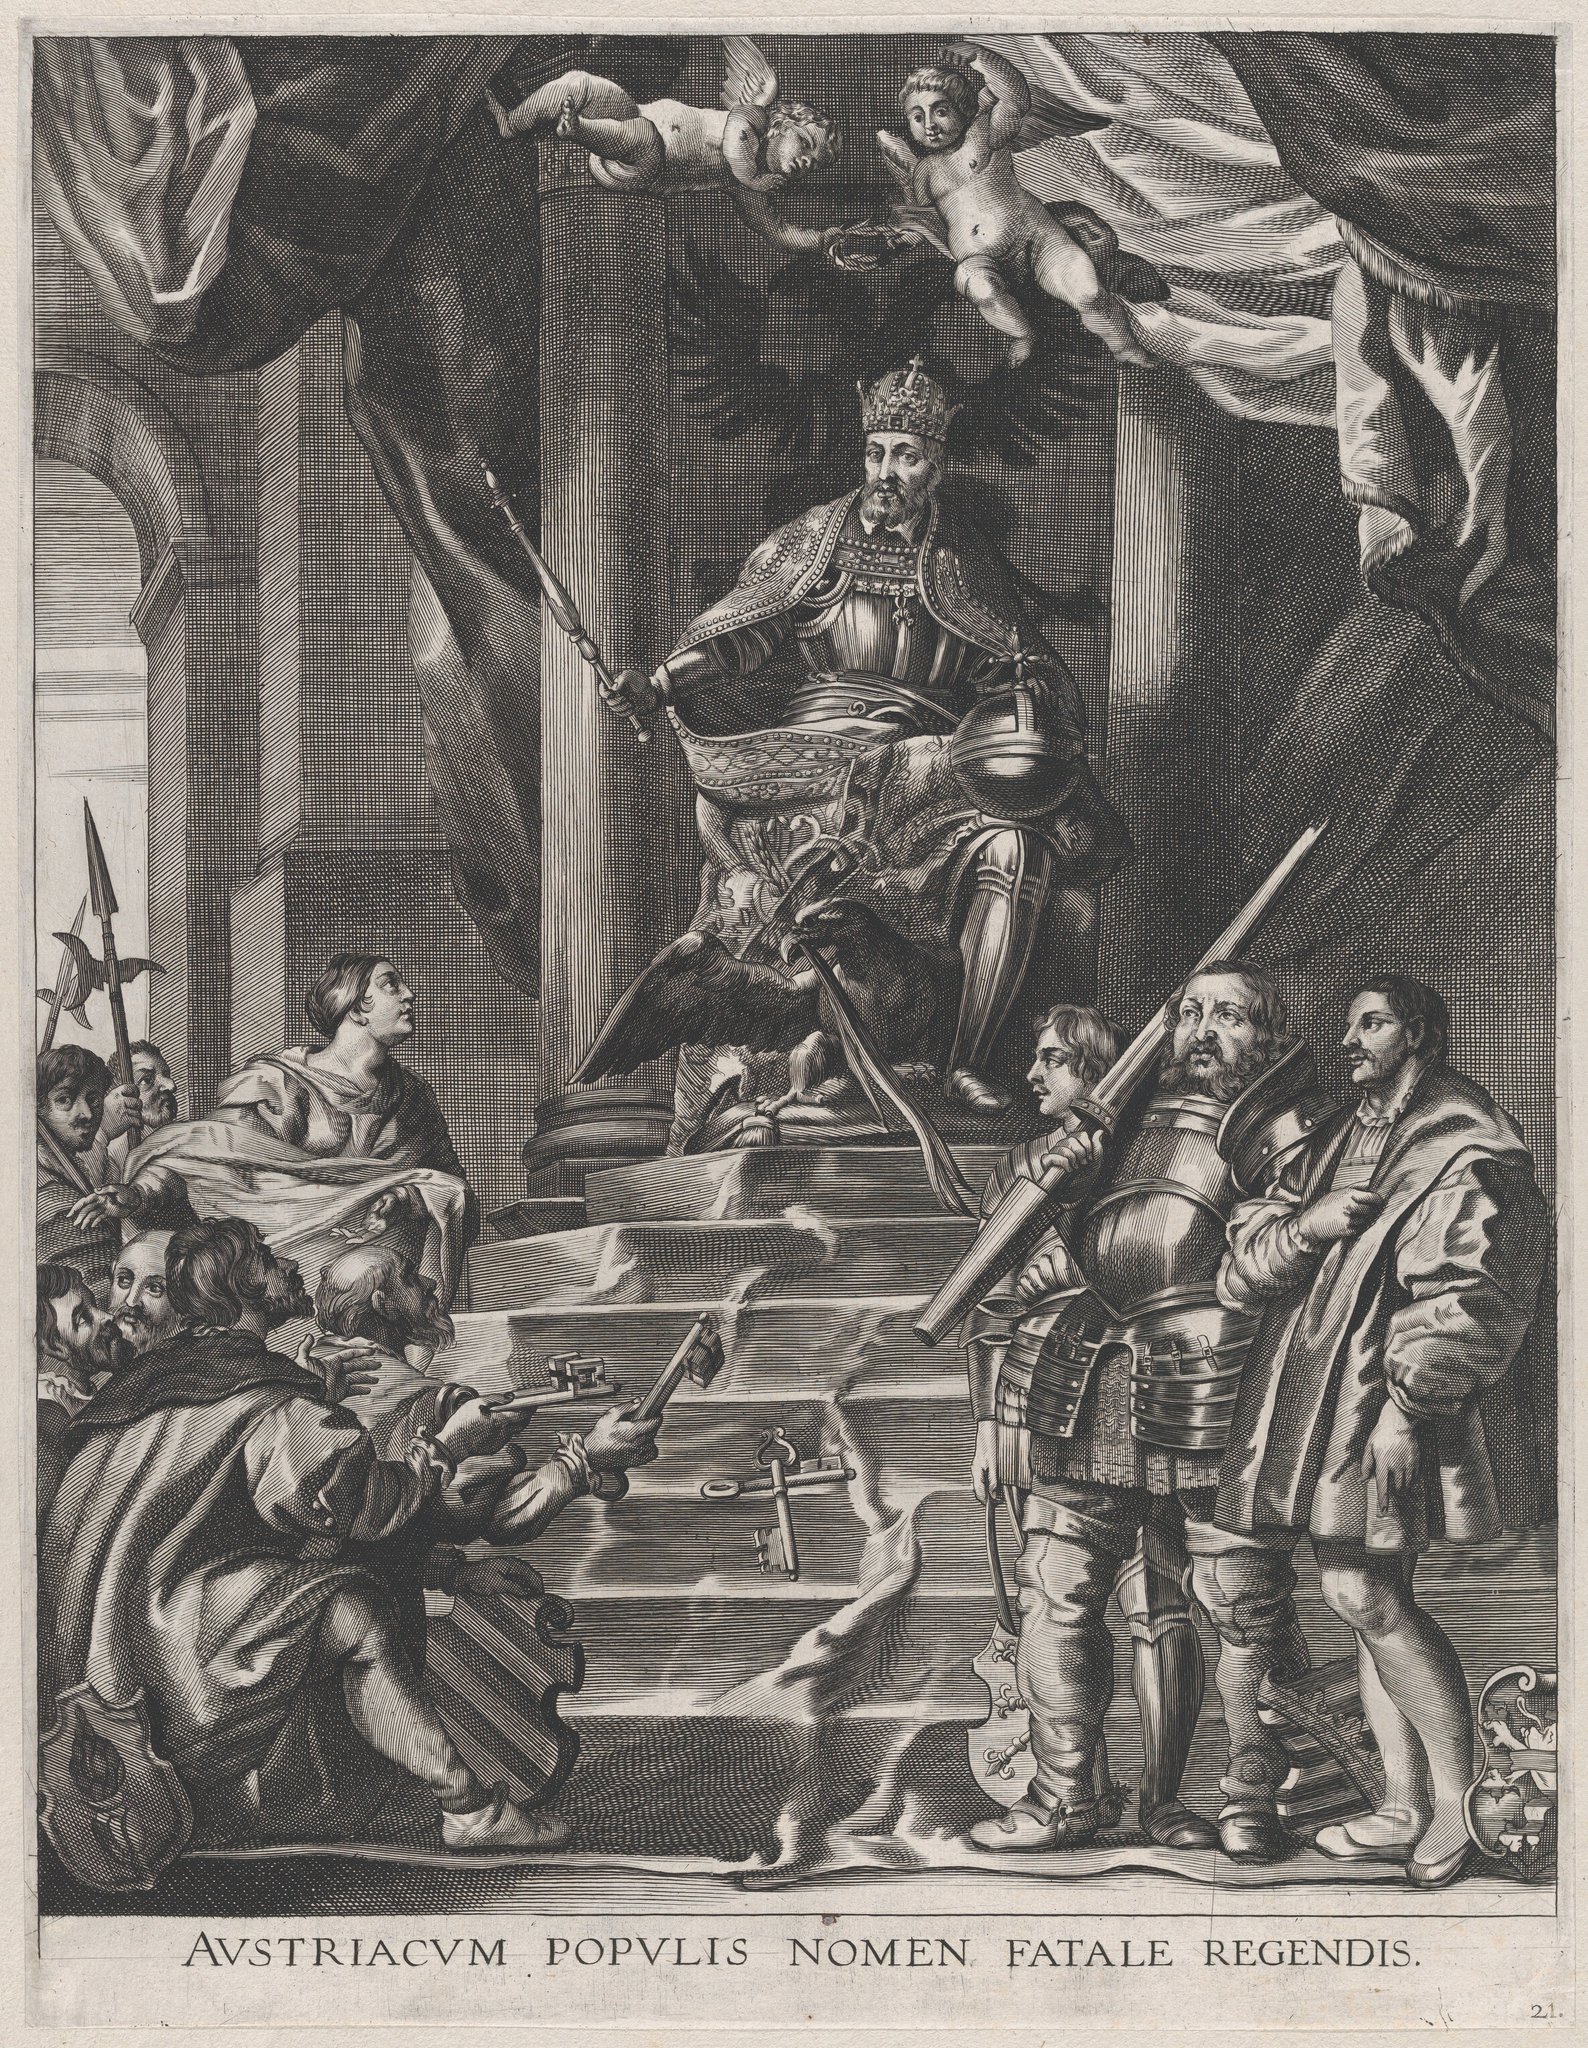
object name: print, fete, ornament architecture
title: Plate 21: Emperor Charles V being offered the keys of Saxony and Hesse; from Guillielmus Becanus's 'Serenissimi Principis Ferdinandi, Hispaniarum Infantis...'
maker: anton van der does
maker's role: artist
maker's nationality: flemish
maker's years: 1609-1680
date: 1636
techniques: engraving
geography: antwerp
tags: men